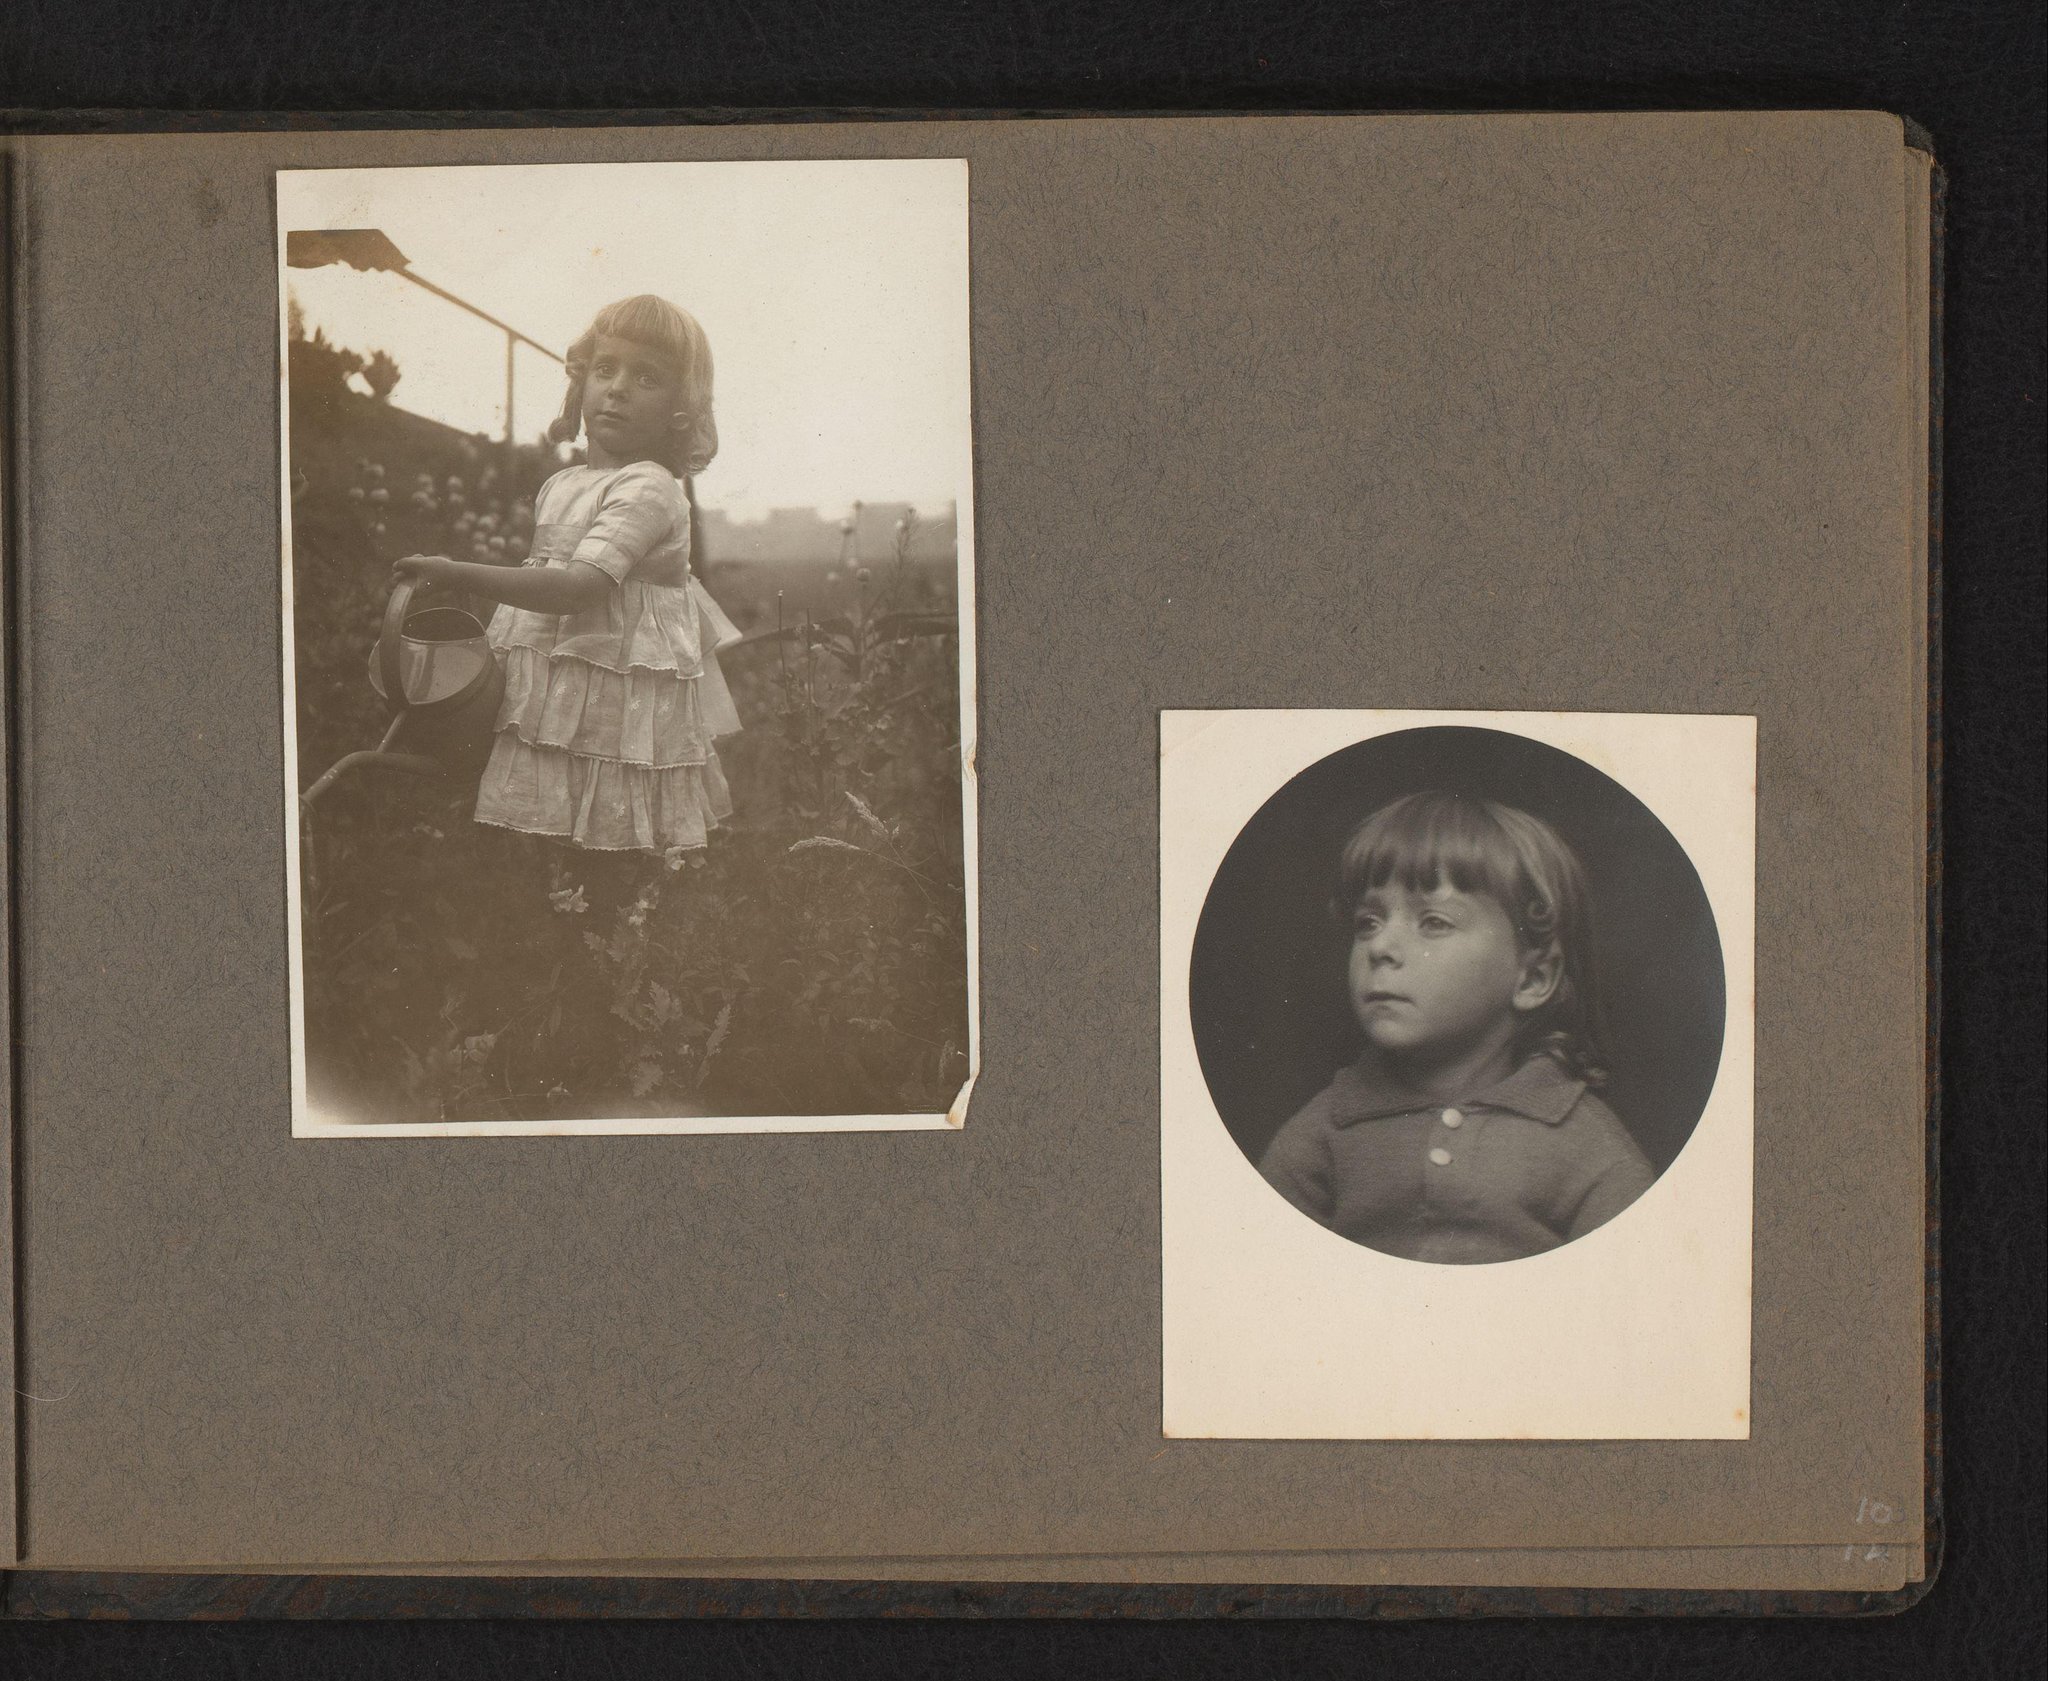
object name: album leaf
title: Meisje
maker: Anonymous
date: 1900-1912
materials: cardboard, photographic support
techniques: gelatin silver print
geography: netherlands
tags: parents with their children, girl (child between toddler and youth), (playing with) dolls, netherlands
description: Albumblad met twee foto's van een meisje met gieter in de tuin en rond portret. Onderdeel van een familiealbum uit de periode 1900-1912.